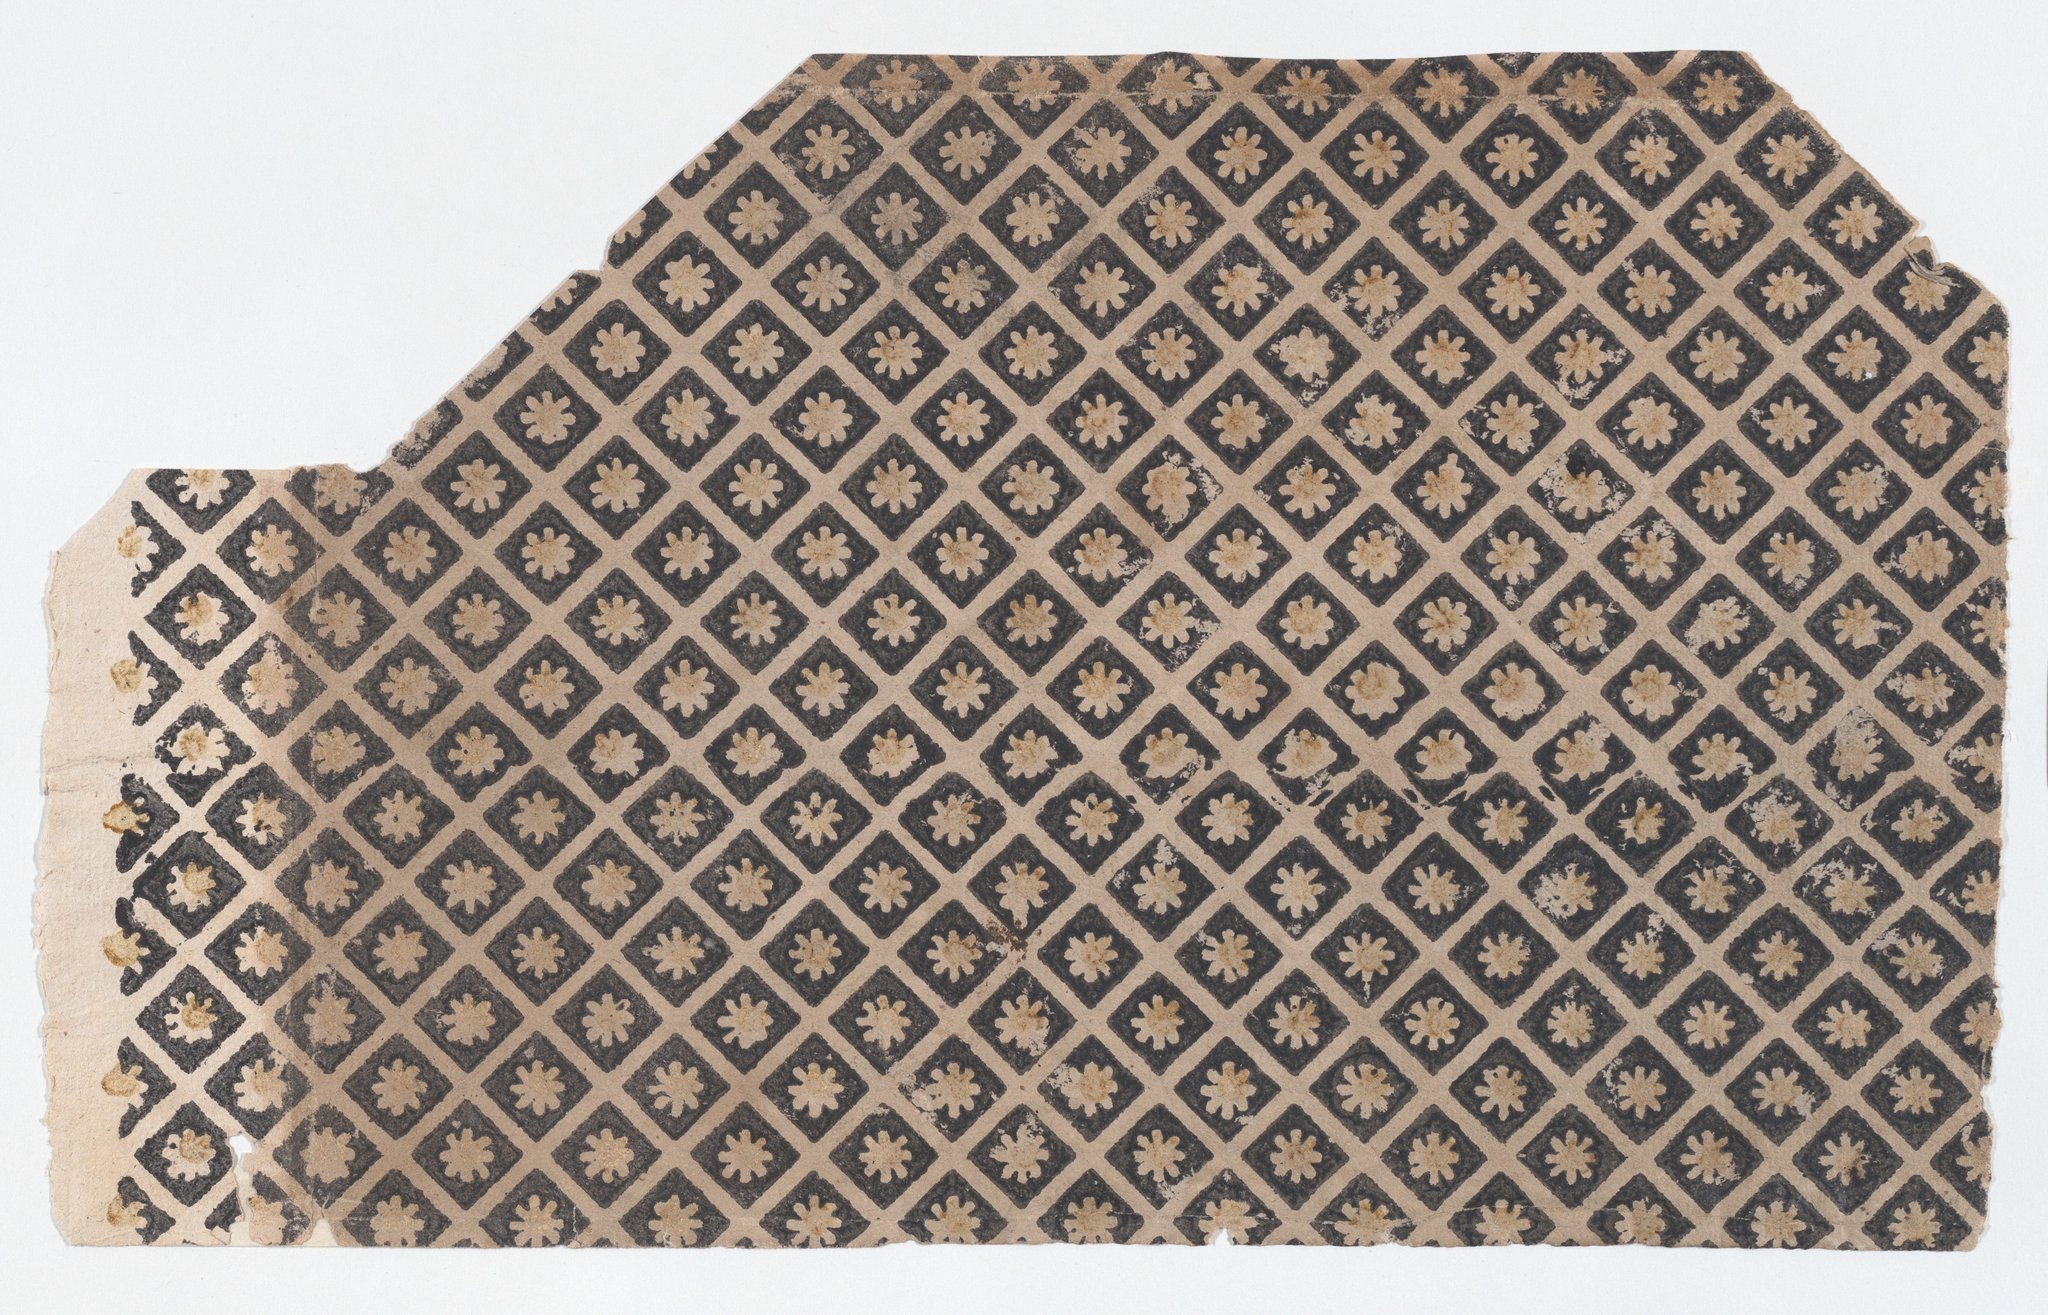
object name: print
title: Sheet with overall pattern of flowers within squares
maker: Anonymous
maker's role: artist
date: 1801-1900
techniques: relief print